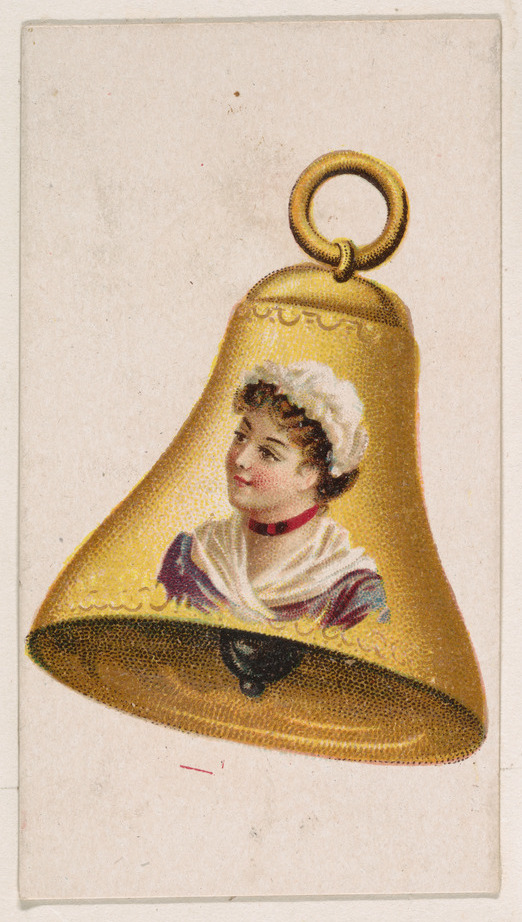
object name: print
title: Bell, from the Novelties series (N228, Type 5) issued by Kinney Bros.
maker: kinney brothers tobacco company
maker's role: publisher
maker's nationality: american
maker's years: 1869-2011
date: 1889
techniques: color lithograph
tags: women,bells